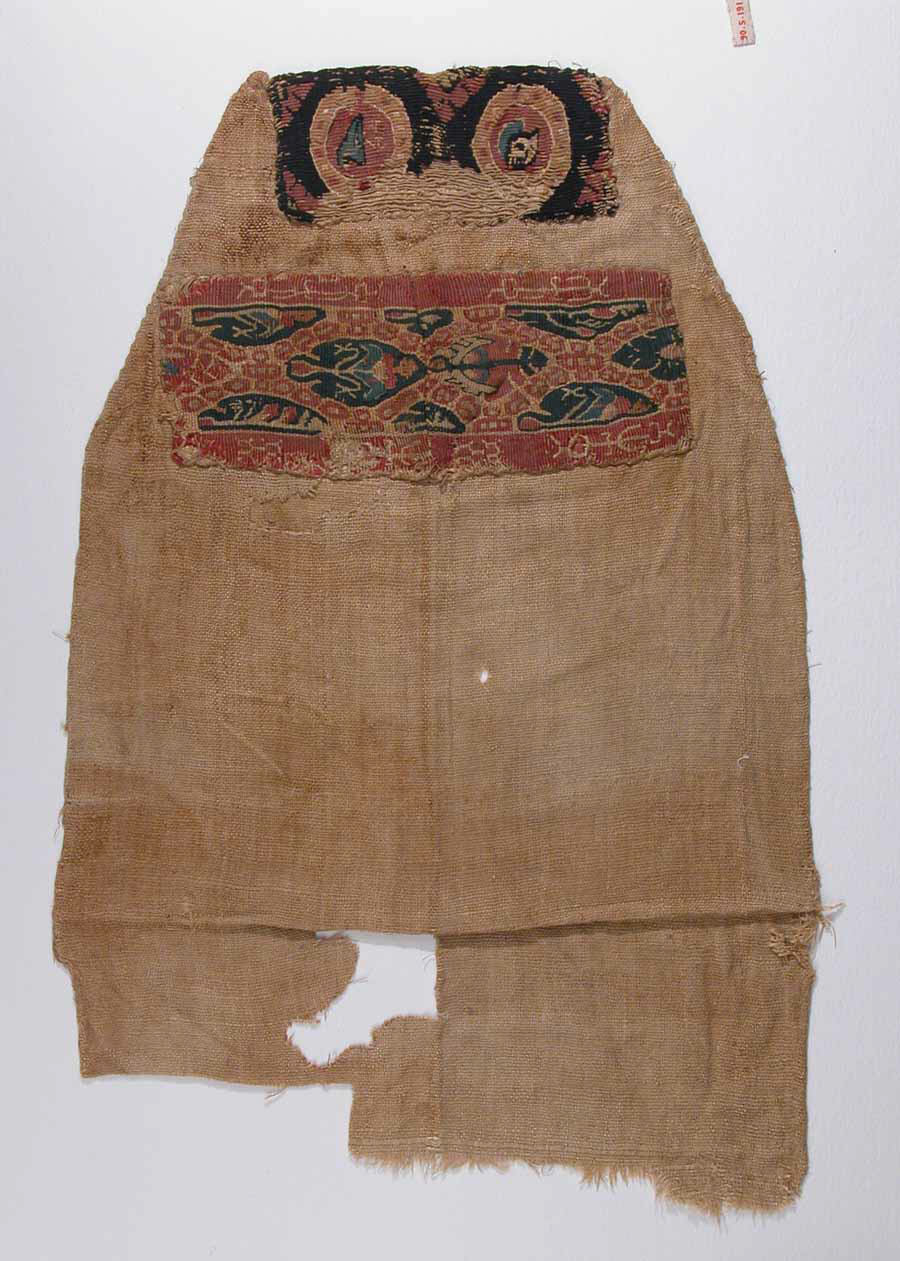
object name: textile fragment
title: Fragment of a Tunic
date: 501-700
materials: linen, wool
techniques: weave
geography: egypt